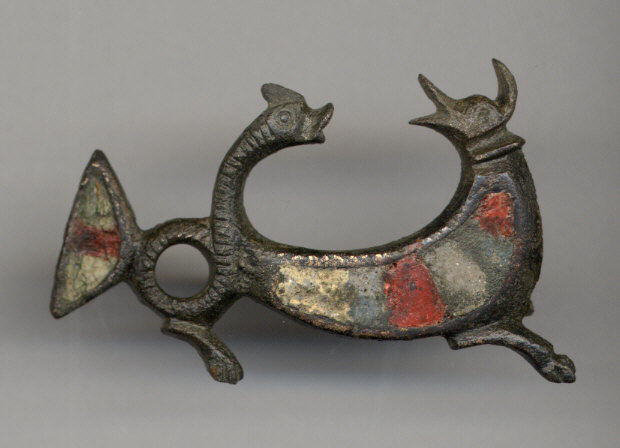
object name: brooch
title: Animal-Shaped Brooch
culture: roman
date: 101-200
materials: copper alloy, enamel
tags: animals